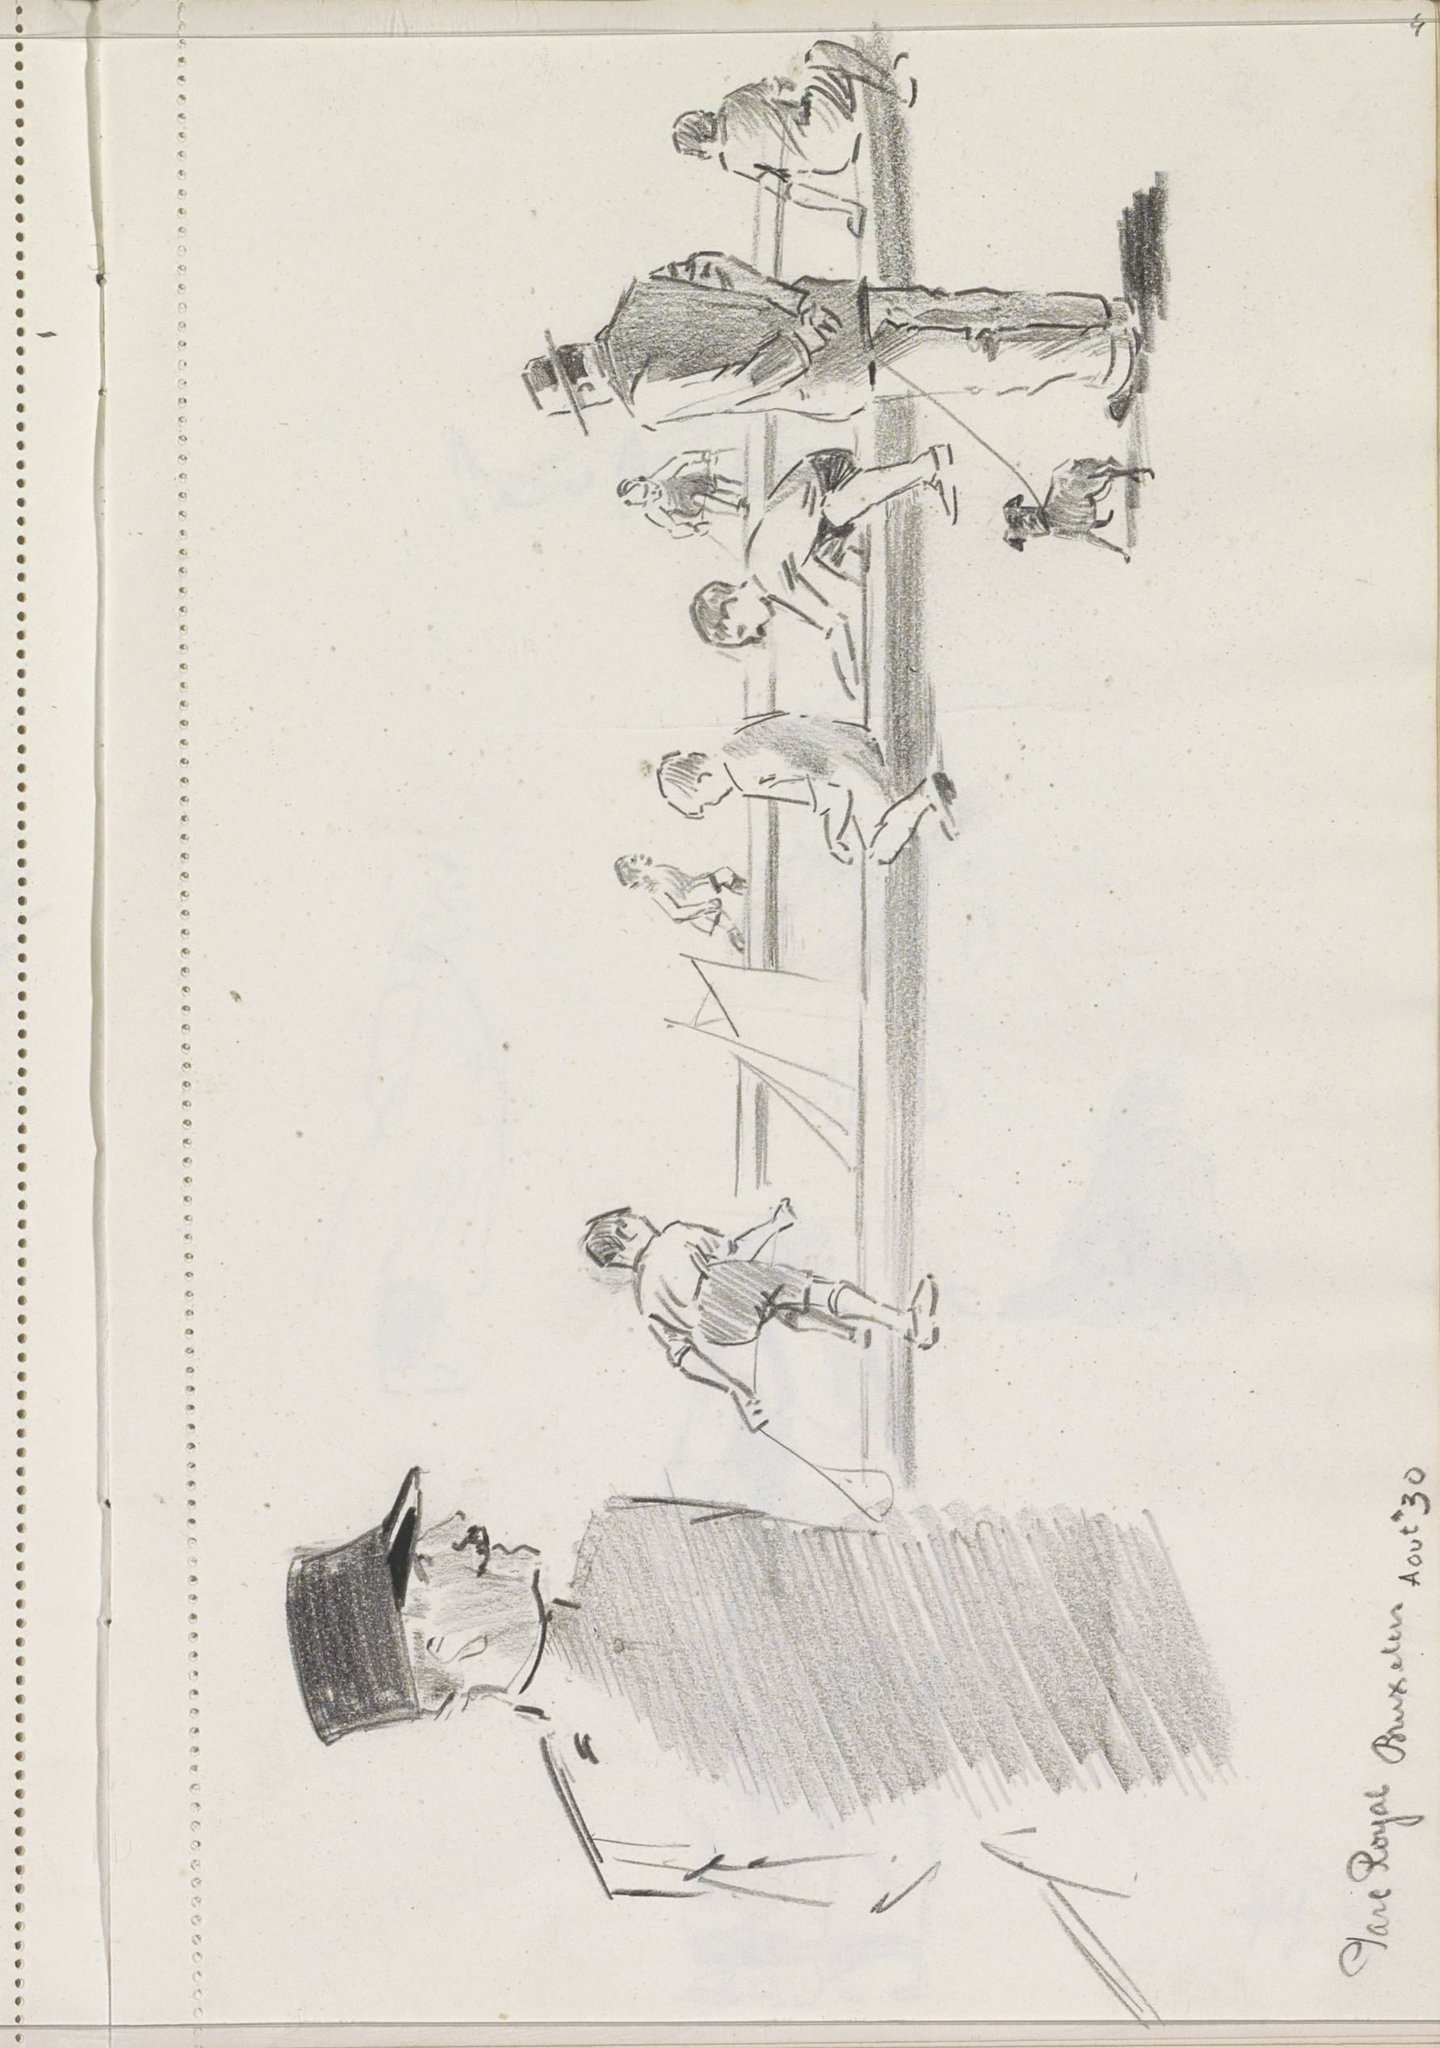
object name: sketchbook leaf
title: Figuren en spelende kinderen bij een fontein op het Koningsplein te Brussel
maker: otto verhagen (i)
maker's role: draughtsman, print maker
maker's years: 1885-1951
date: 1908-1930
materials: chalk, paper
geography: brussels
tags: square, place, circus, etc., street (+ city(-scape) with figures, staffage), (playing with) boats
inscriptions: date and inscription: ‘Place Royal/ Bruxelles/ Aout '30’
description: De kinderen laten speelgoedbootjes op het water varen. Pagina 4 uit een schetsboek met 60 bladen.